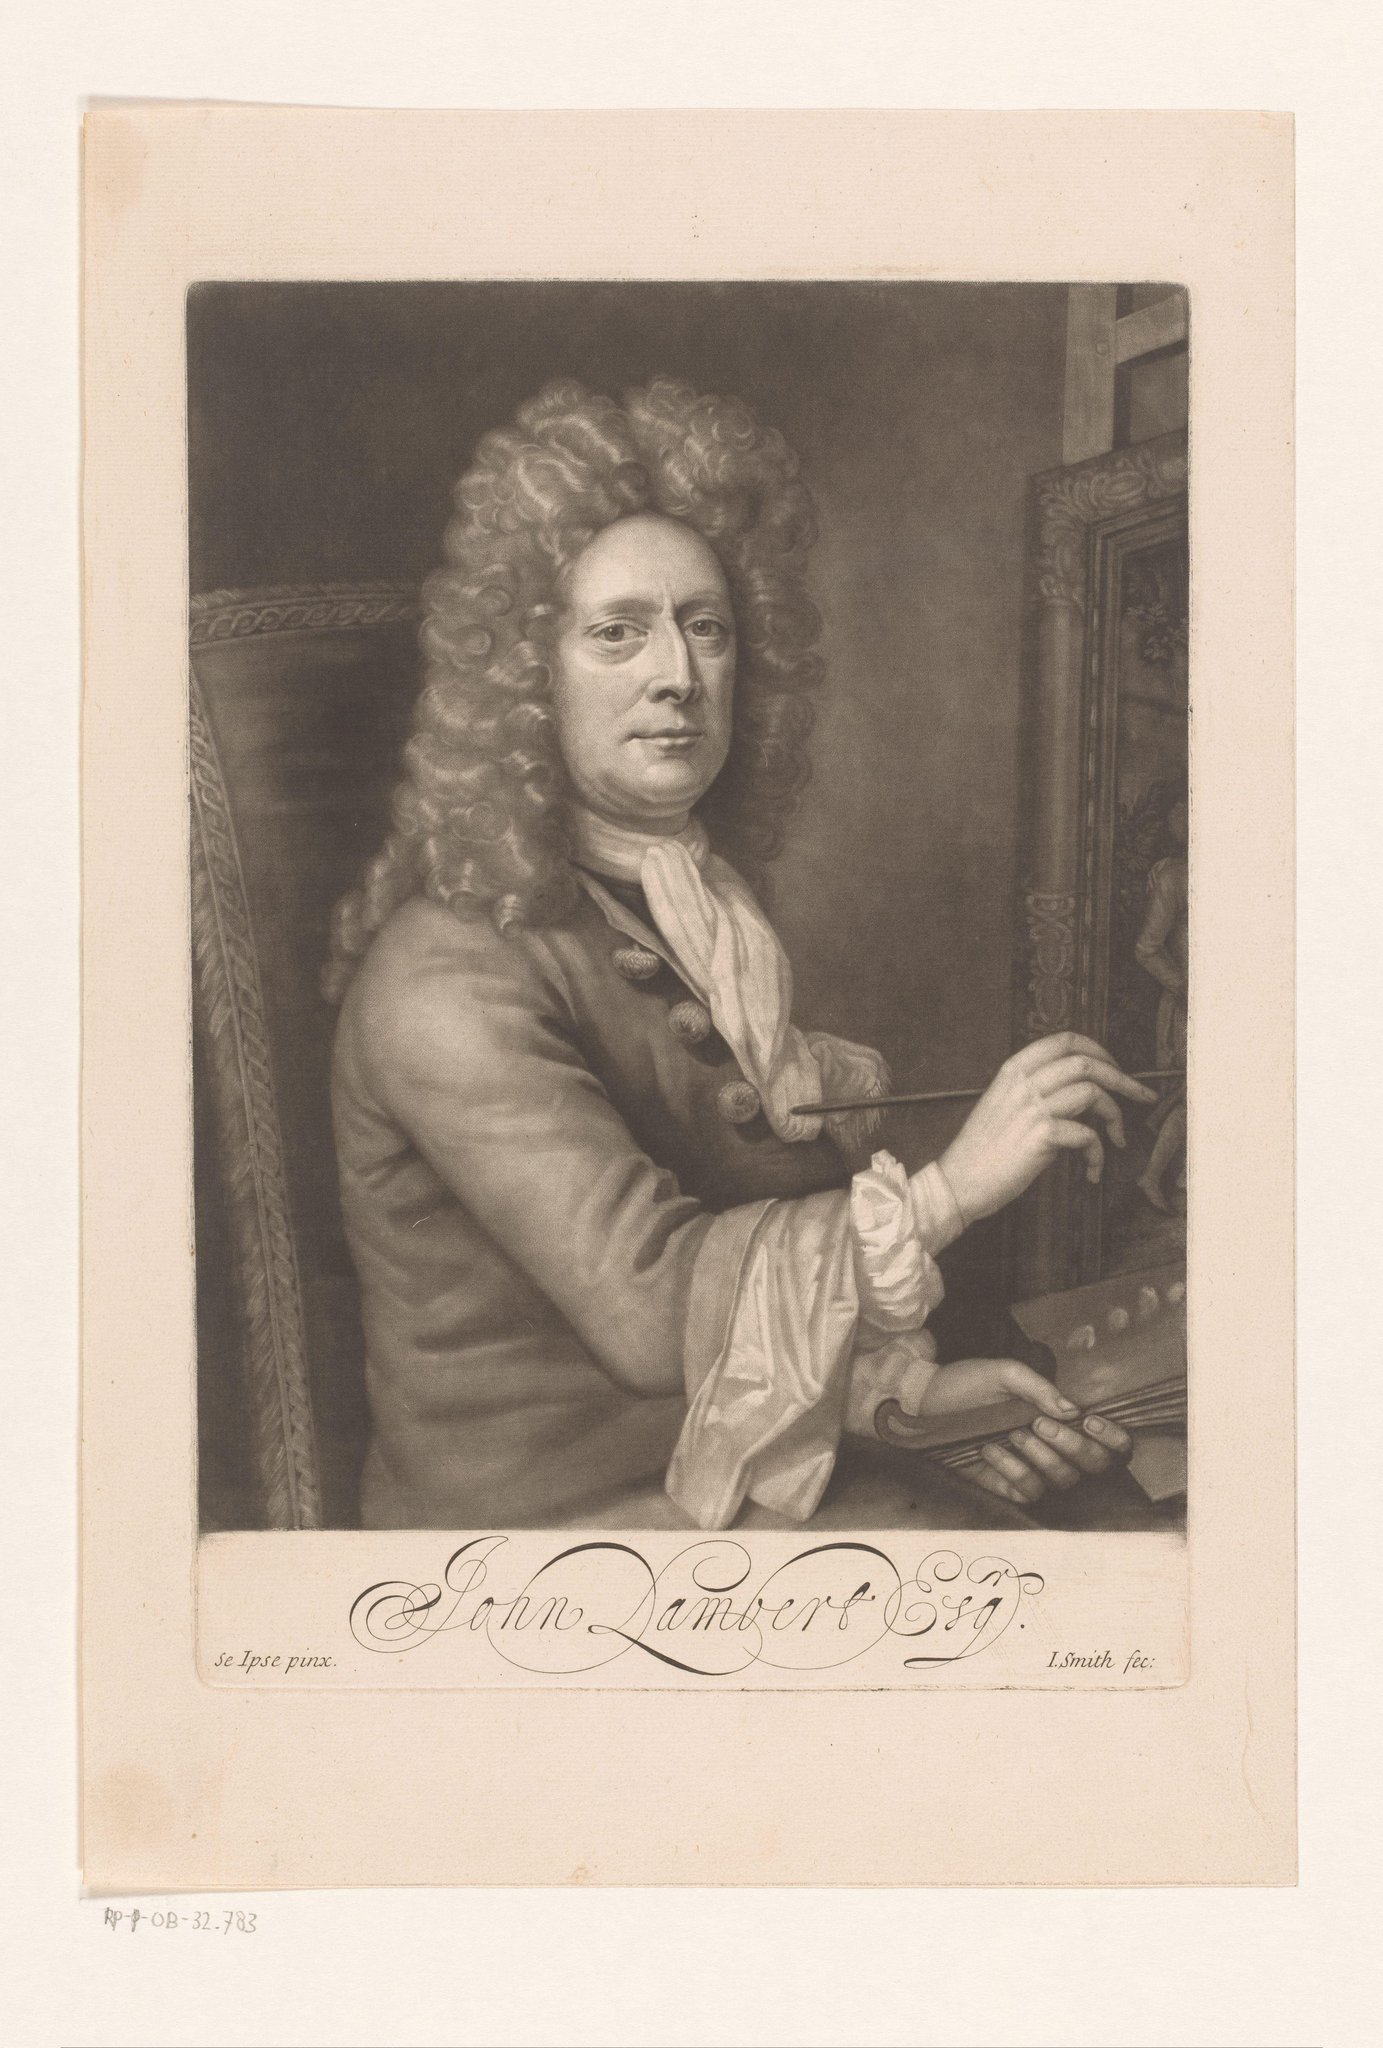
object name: print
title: Portret van John Lambert Esqr.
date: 1662-1742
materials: paper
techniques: mezzotint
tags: painter, john lambert (ii), historical persons, portrait, self-portrait of painter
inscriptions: collector's mark: Lugt 240